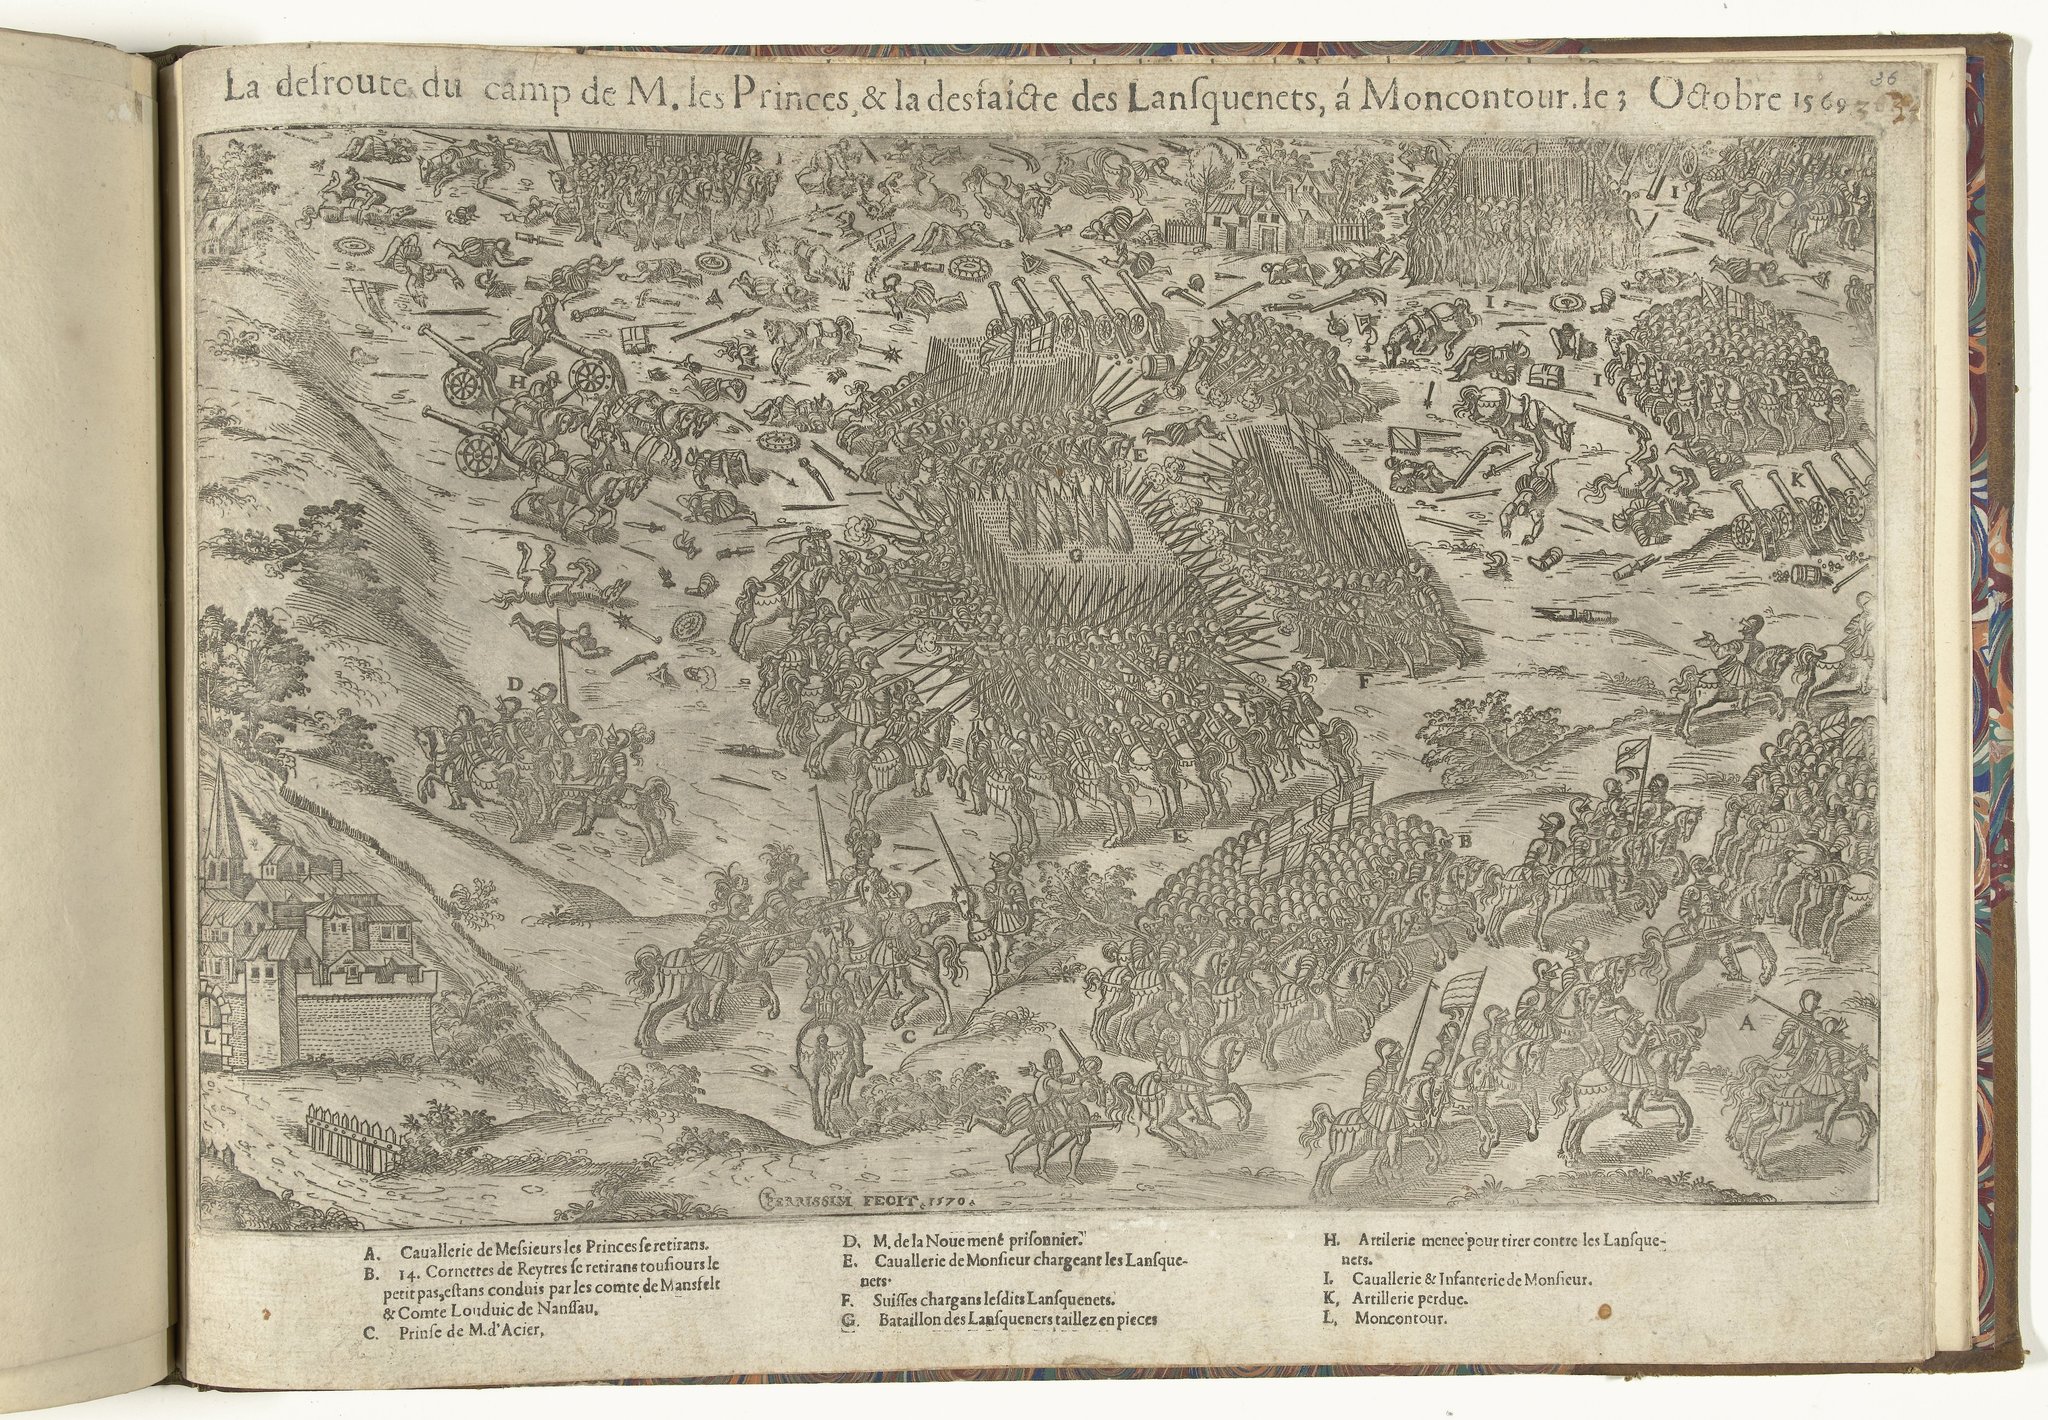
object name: print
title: Slag bij Moncontour, 1569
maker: jean perrissin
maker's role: print maker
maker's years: 1536-1611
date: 1570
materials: paper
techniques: etching, letterpress printing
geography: france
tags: battle, fighting in general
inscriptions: date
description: Slag bij Moncontour, 3 oktober 1569. Gezicht van de veldslag, rechtsonder verlaat het leger van de prins het slagveld. In het onderschrift de legenda A-L in het Frans. Ongenummerd.